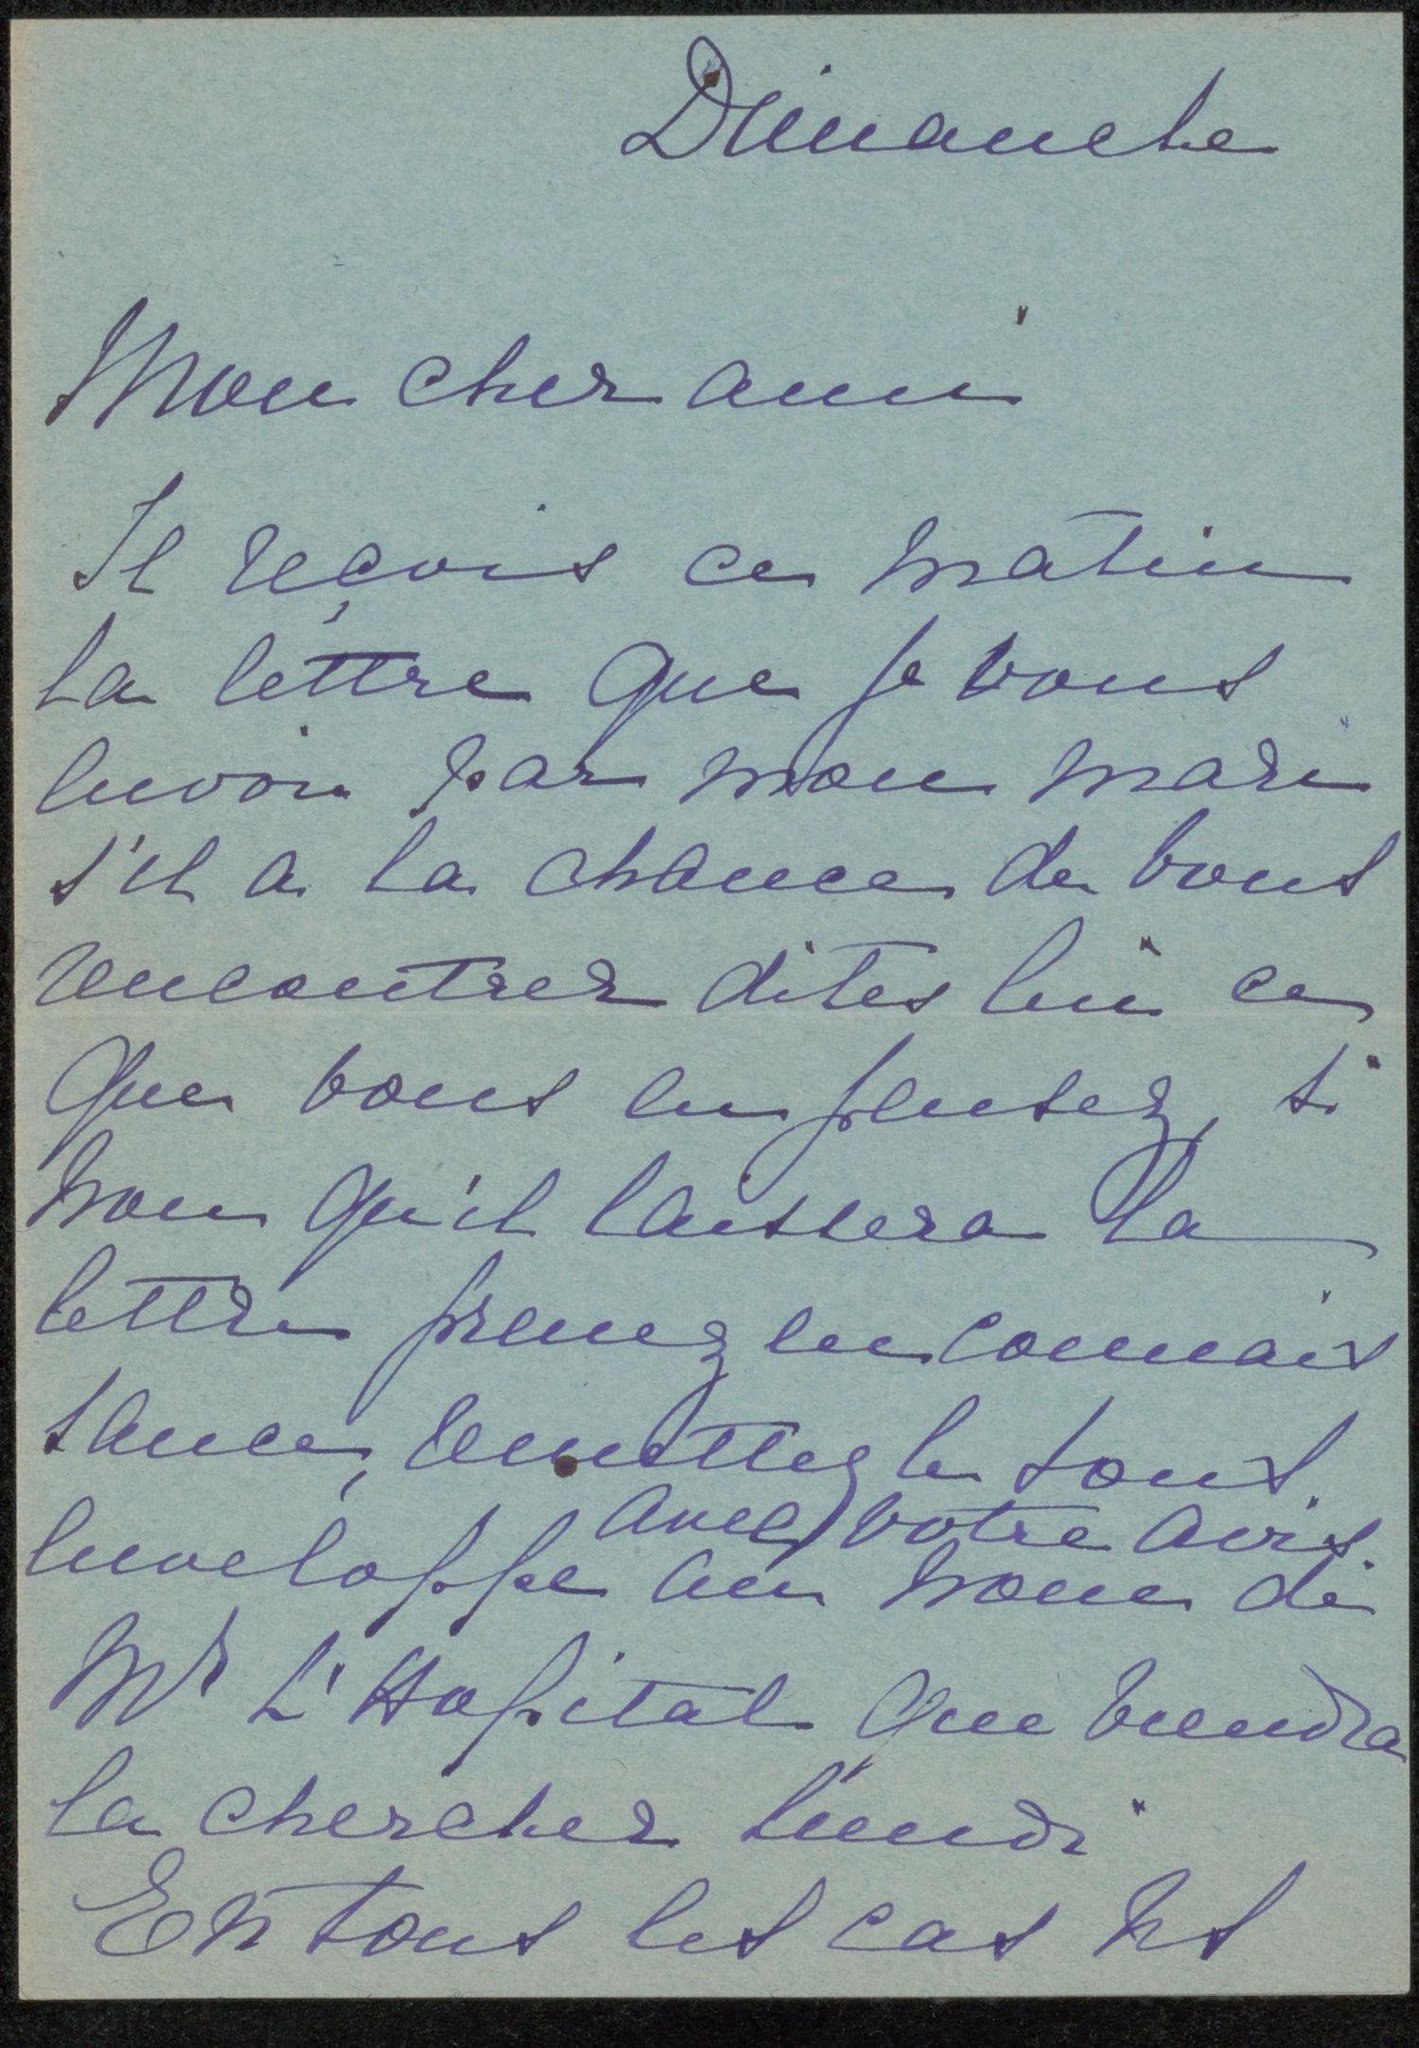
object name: letter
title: Brief aan Philip Zilcken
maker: cato l hôpital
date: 1867-1930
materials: ink, paper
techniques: pen, writing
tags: amsterdam, abraham bredius, the hague, draughtsman, philip zilcken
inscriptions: collector's mark: ‘RPK’